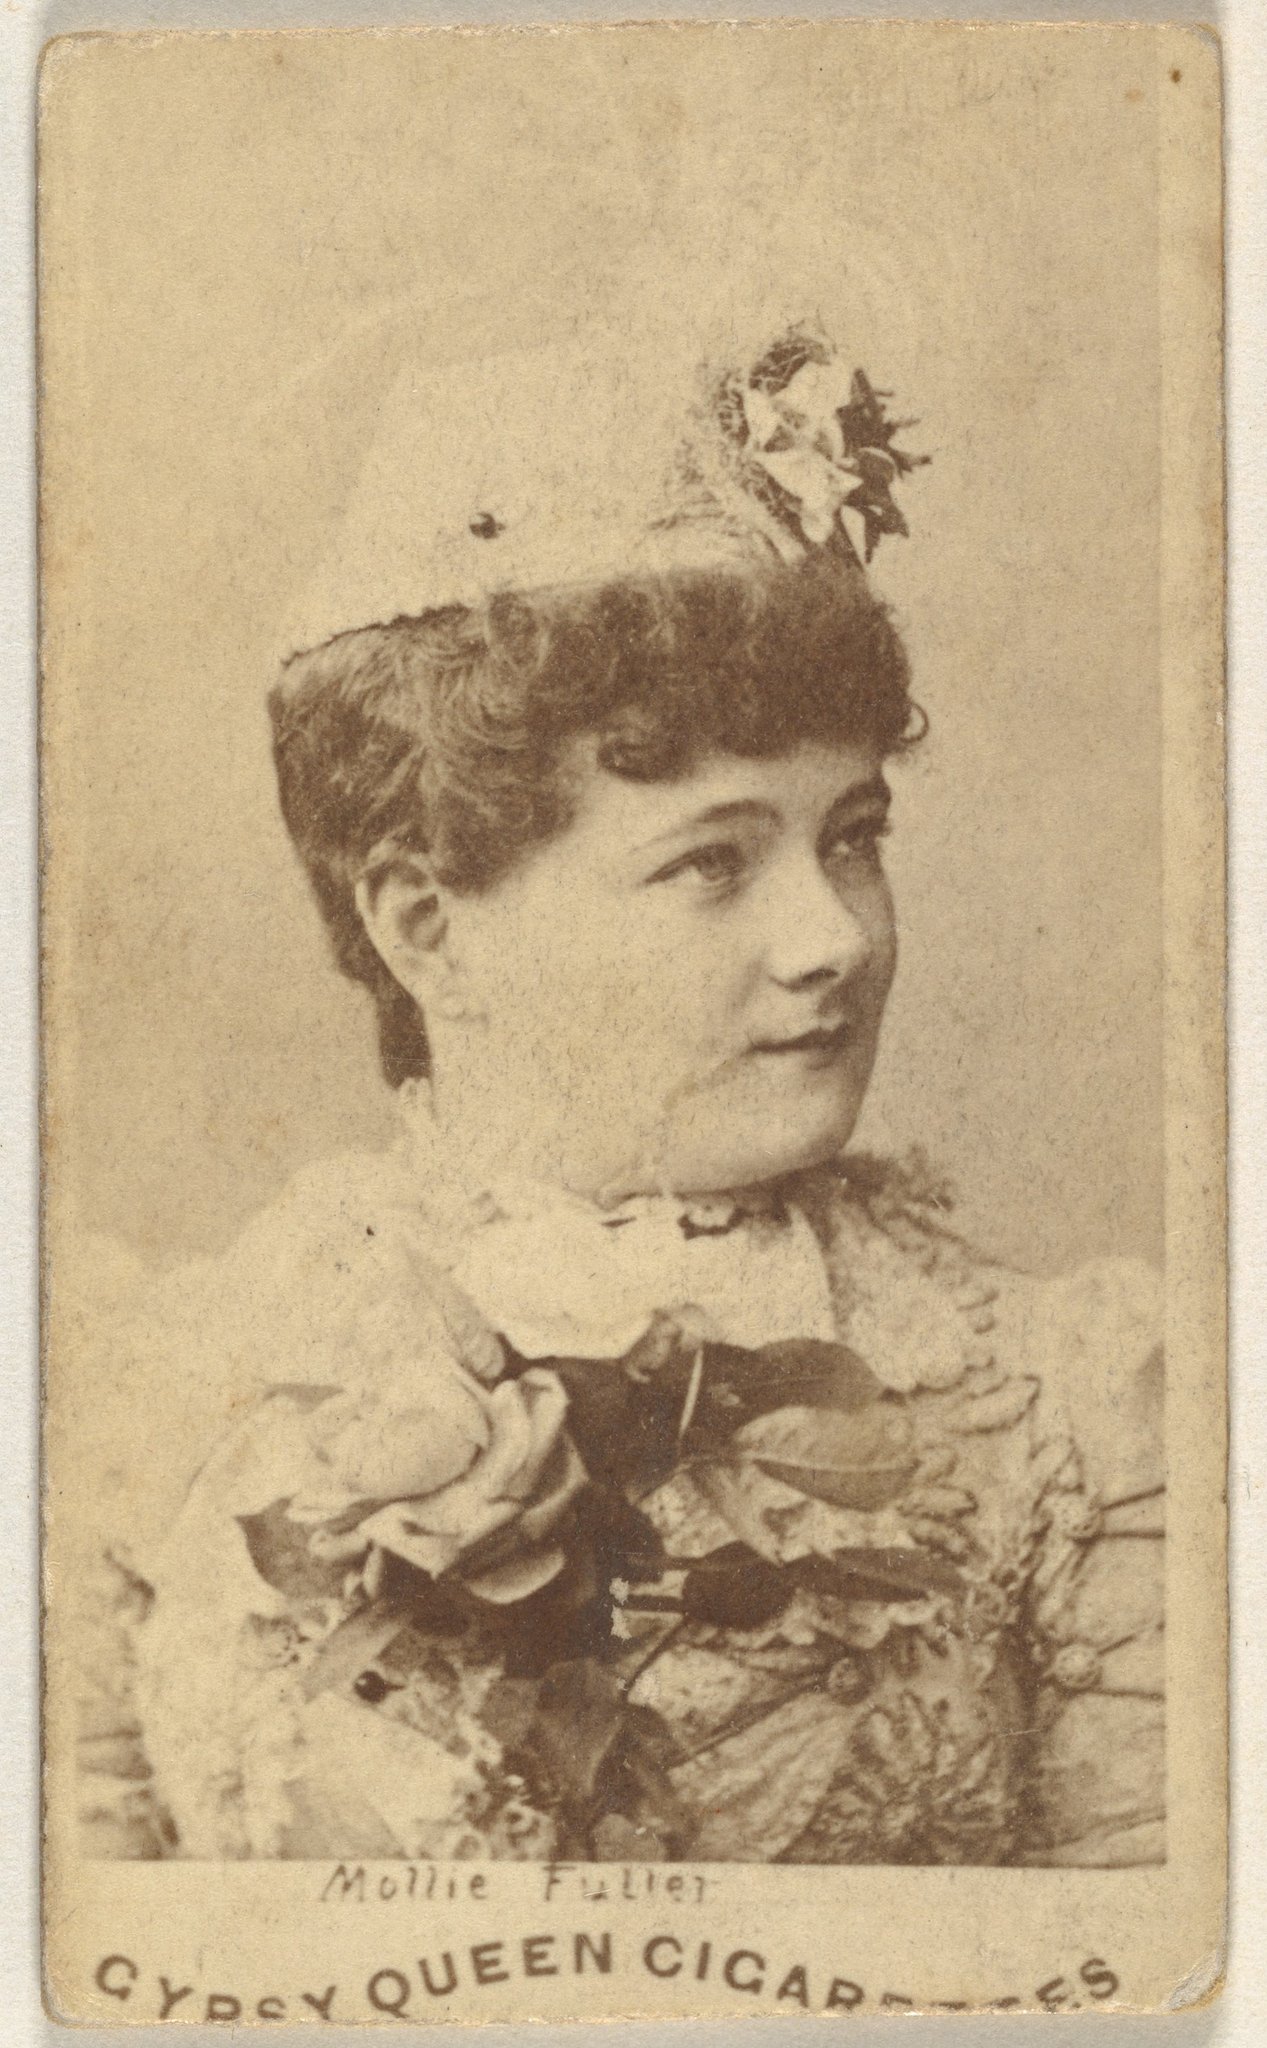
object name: photograph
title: Mollie Fuller, from the Actors and Actresses series (N171) for Gypsy Queen Cigarettes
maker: goodwin & company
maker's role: publisher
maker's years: 1850-1950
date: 1886-1890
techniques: albumen silver print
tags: portraits,women,actresses